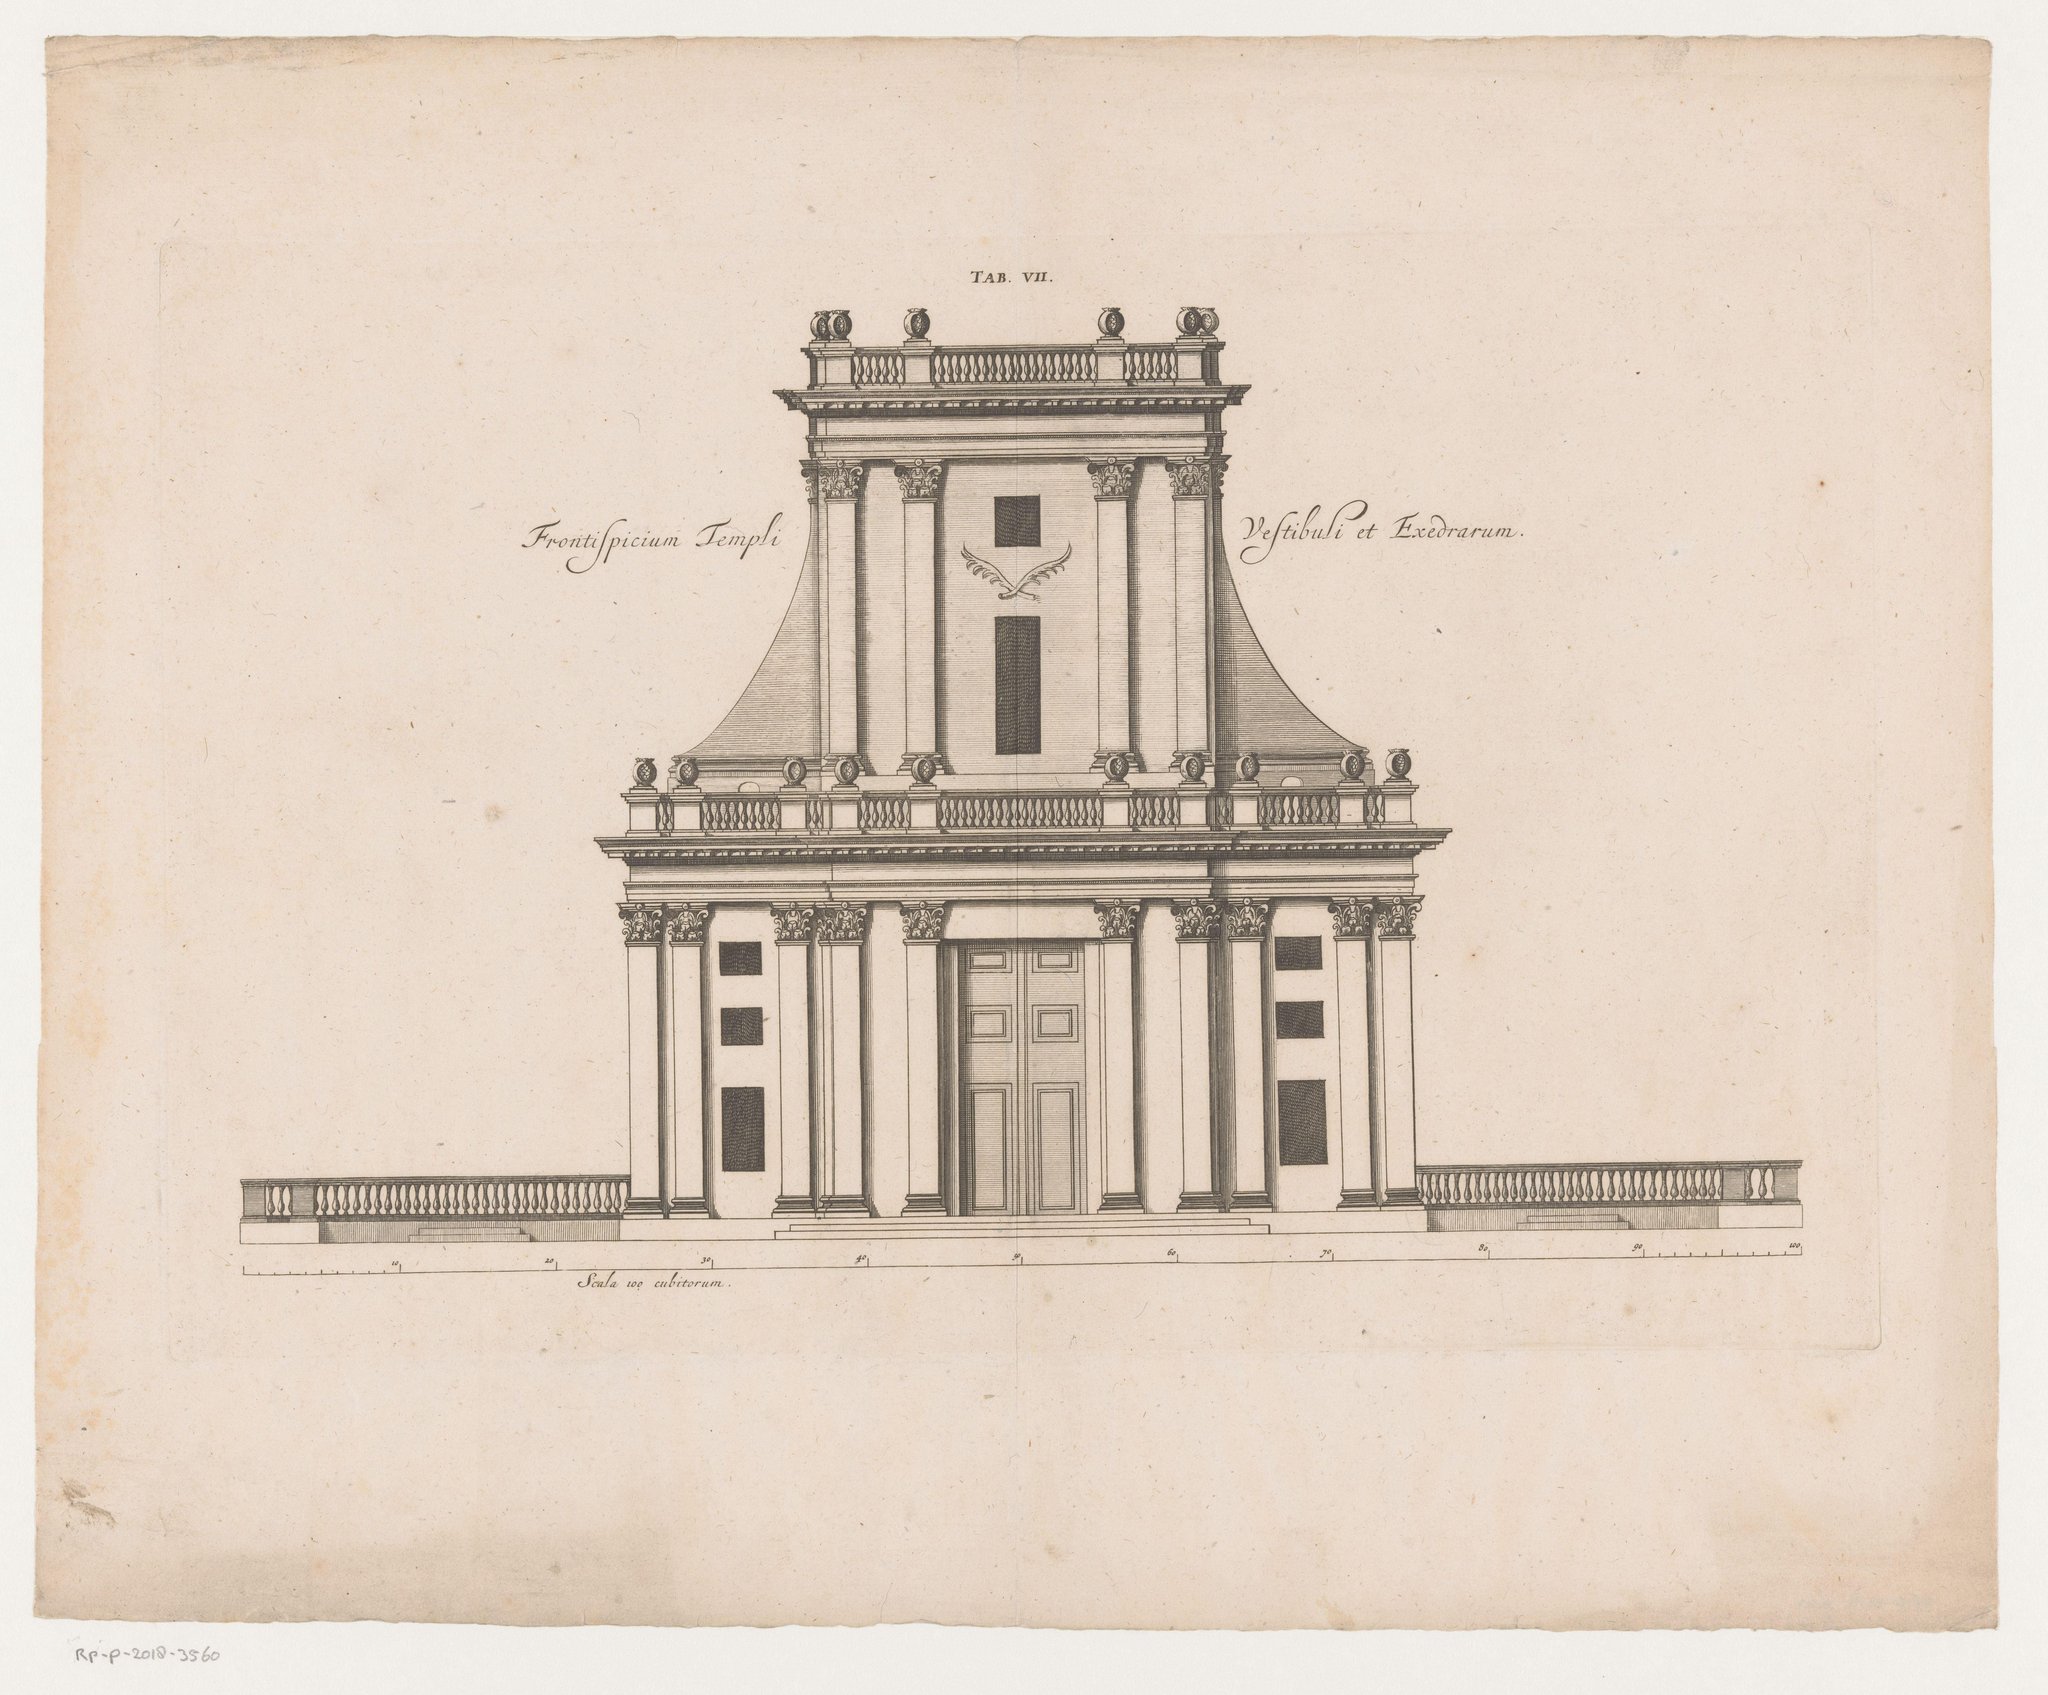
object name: print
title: Vooraanzicht van een gebouw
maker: Anonymous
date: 1650-1750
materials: paper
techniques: engraving, etching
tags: exterior ~ architectural design or model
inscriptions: collector's mark: Lugt 2228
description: Het ontwerp wordt beschreven in: Coccejes, Johannes. Opera Omnia Theologica, Exegetica, Didactica, Polemica, Philosophica. S.l.: Wustius, 1689.